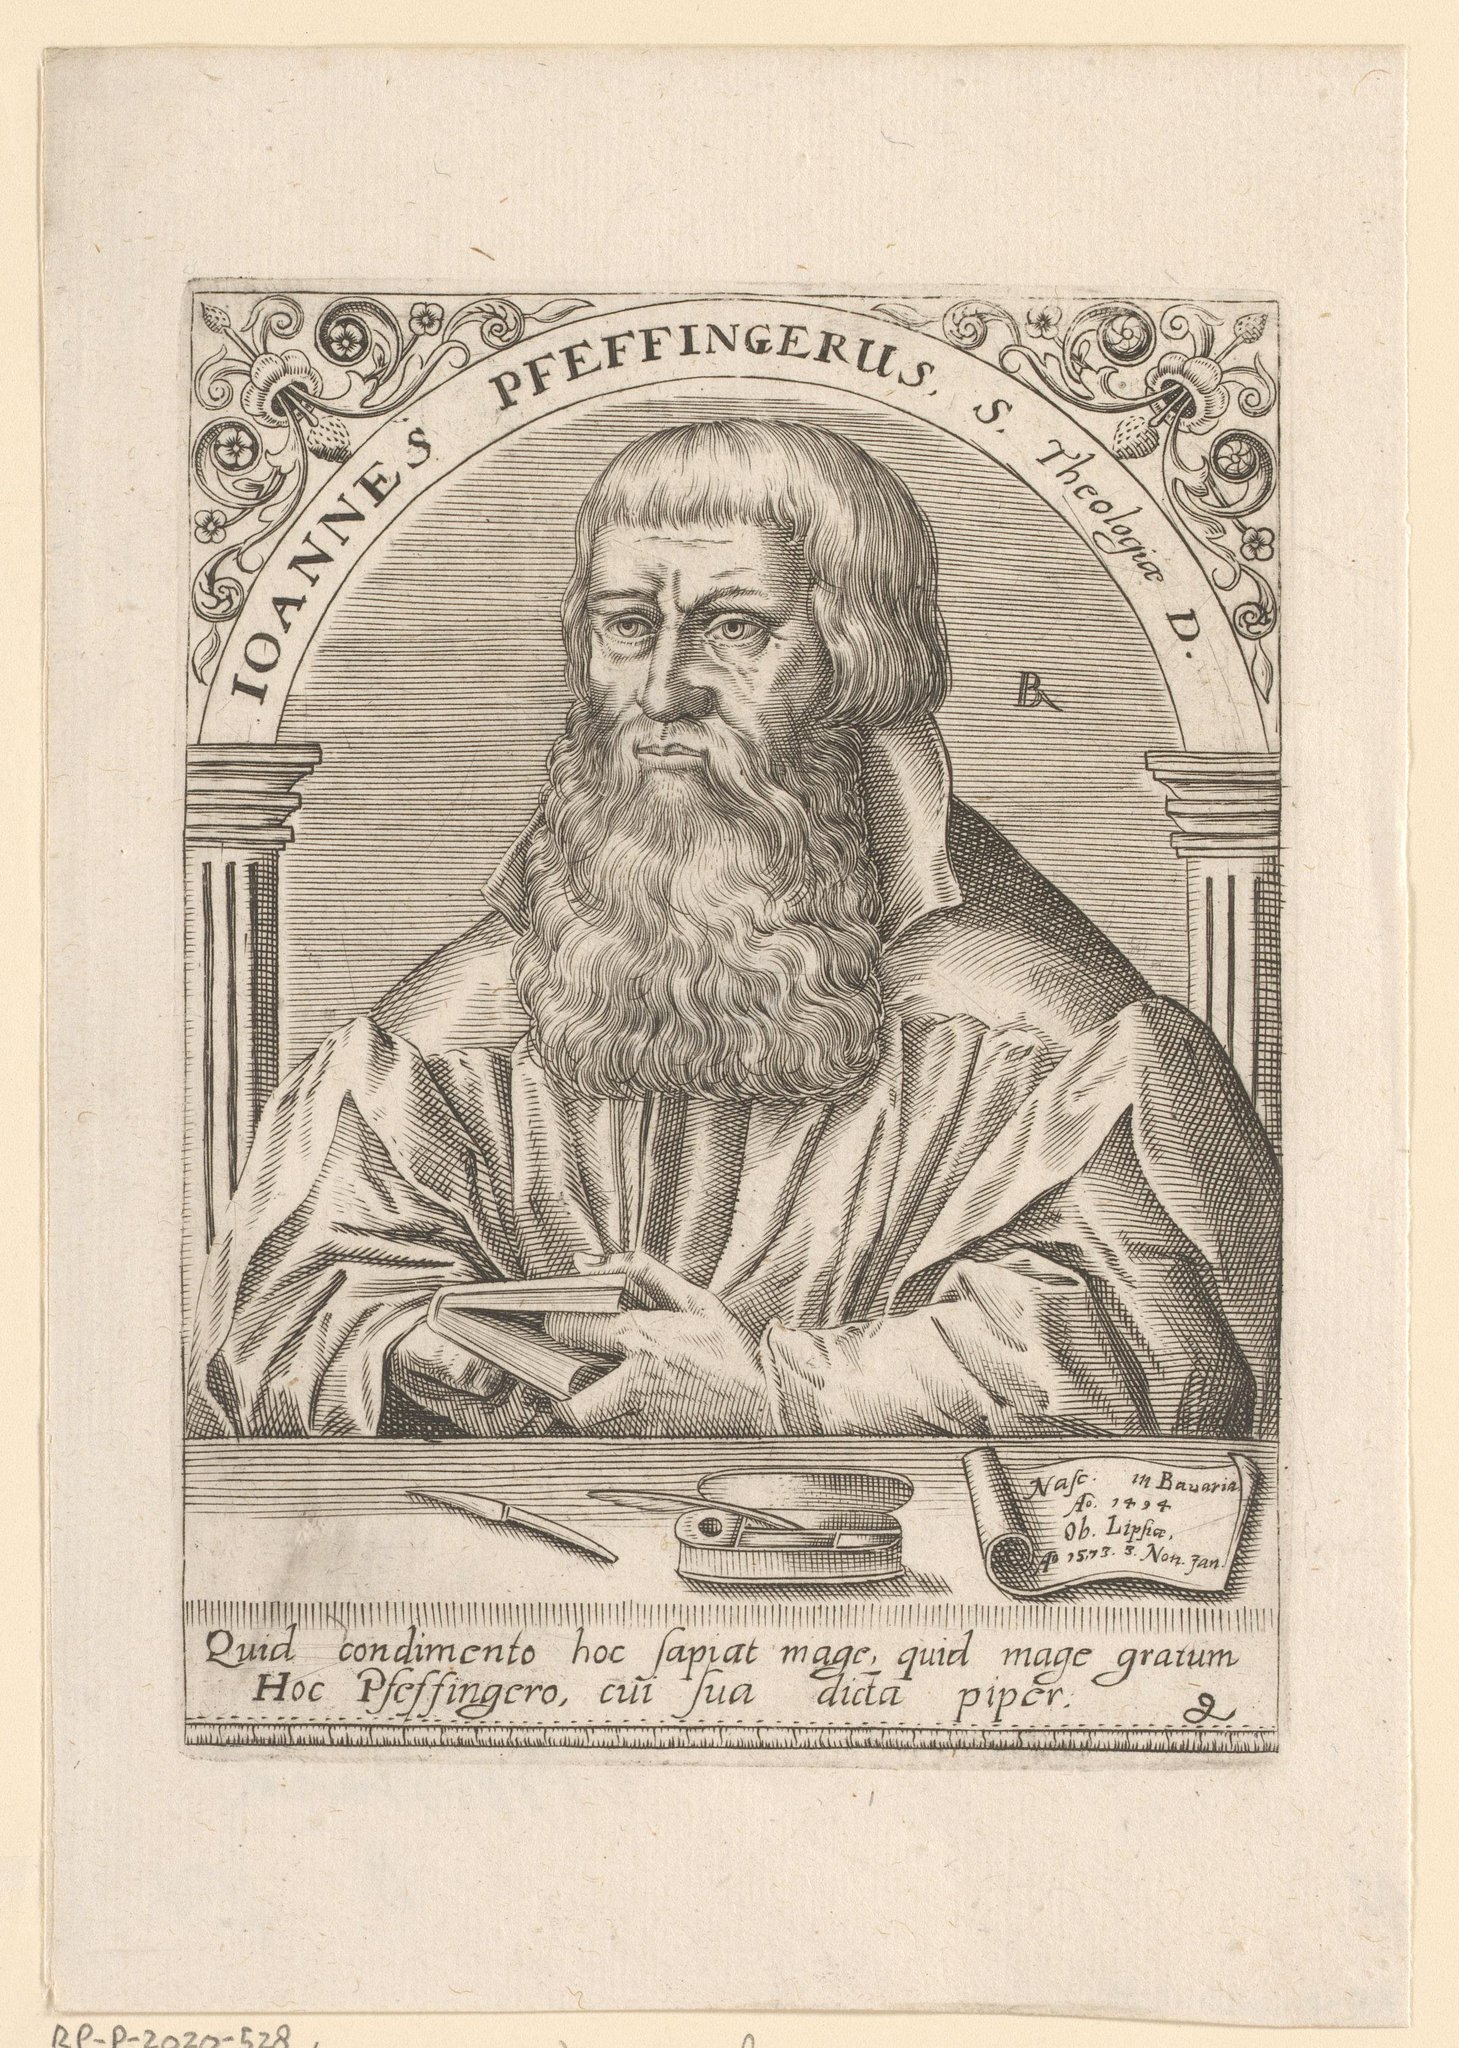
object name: print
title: Ioannes Pfeffingerus. S. theologiae D.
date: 1650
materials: paper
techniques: engraving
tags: theologian, historical persons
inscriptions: collector's mark: Lugt 2228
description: Prent uit: Boissard, Jean Jacques. Bibliotheca chalcographica. 8 dln. Frankfurt am Main: Johannes Ammon, 1650-1652. Prent ook gebruikt in latere edities. Eerdere staat van prent verschenen in: Boissard, Jean Jacques. Icones quinquaginta virorum illustrium doctrina & eruditione praestantium ad vivum effictae. 4 dln. Frankfurt am Main: s.n., 1597-1599. Mogelijk ook gebruikt in latere edities.